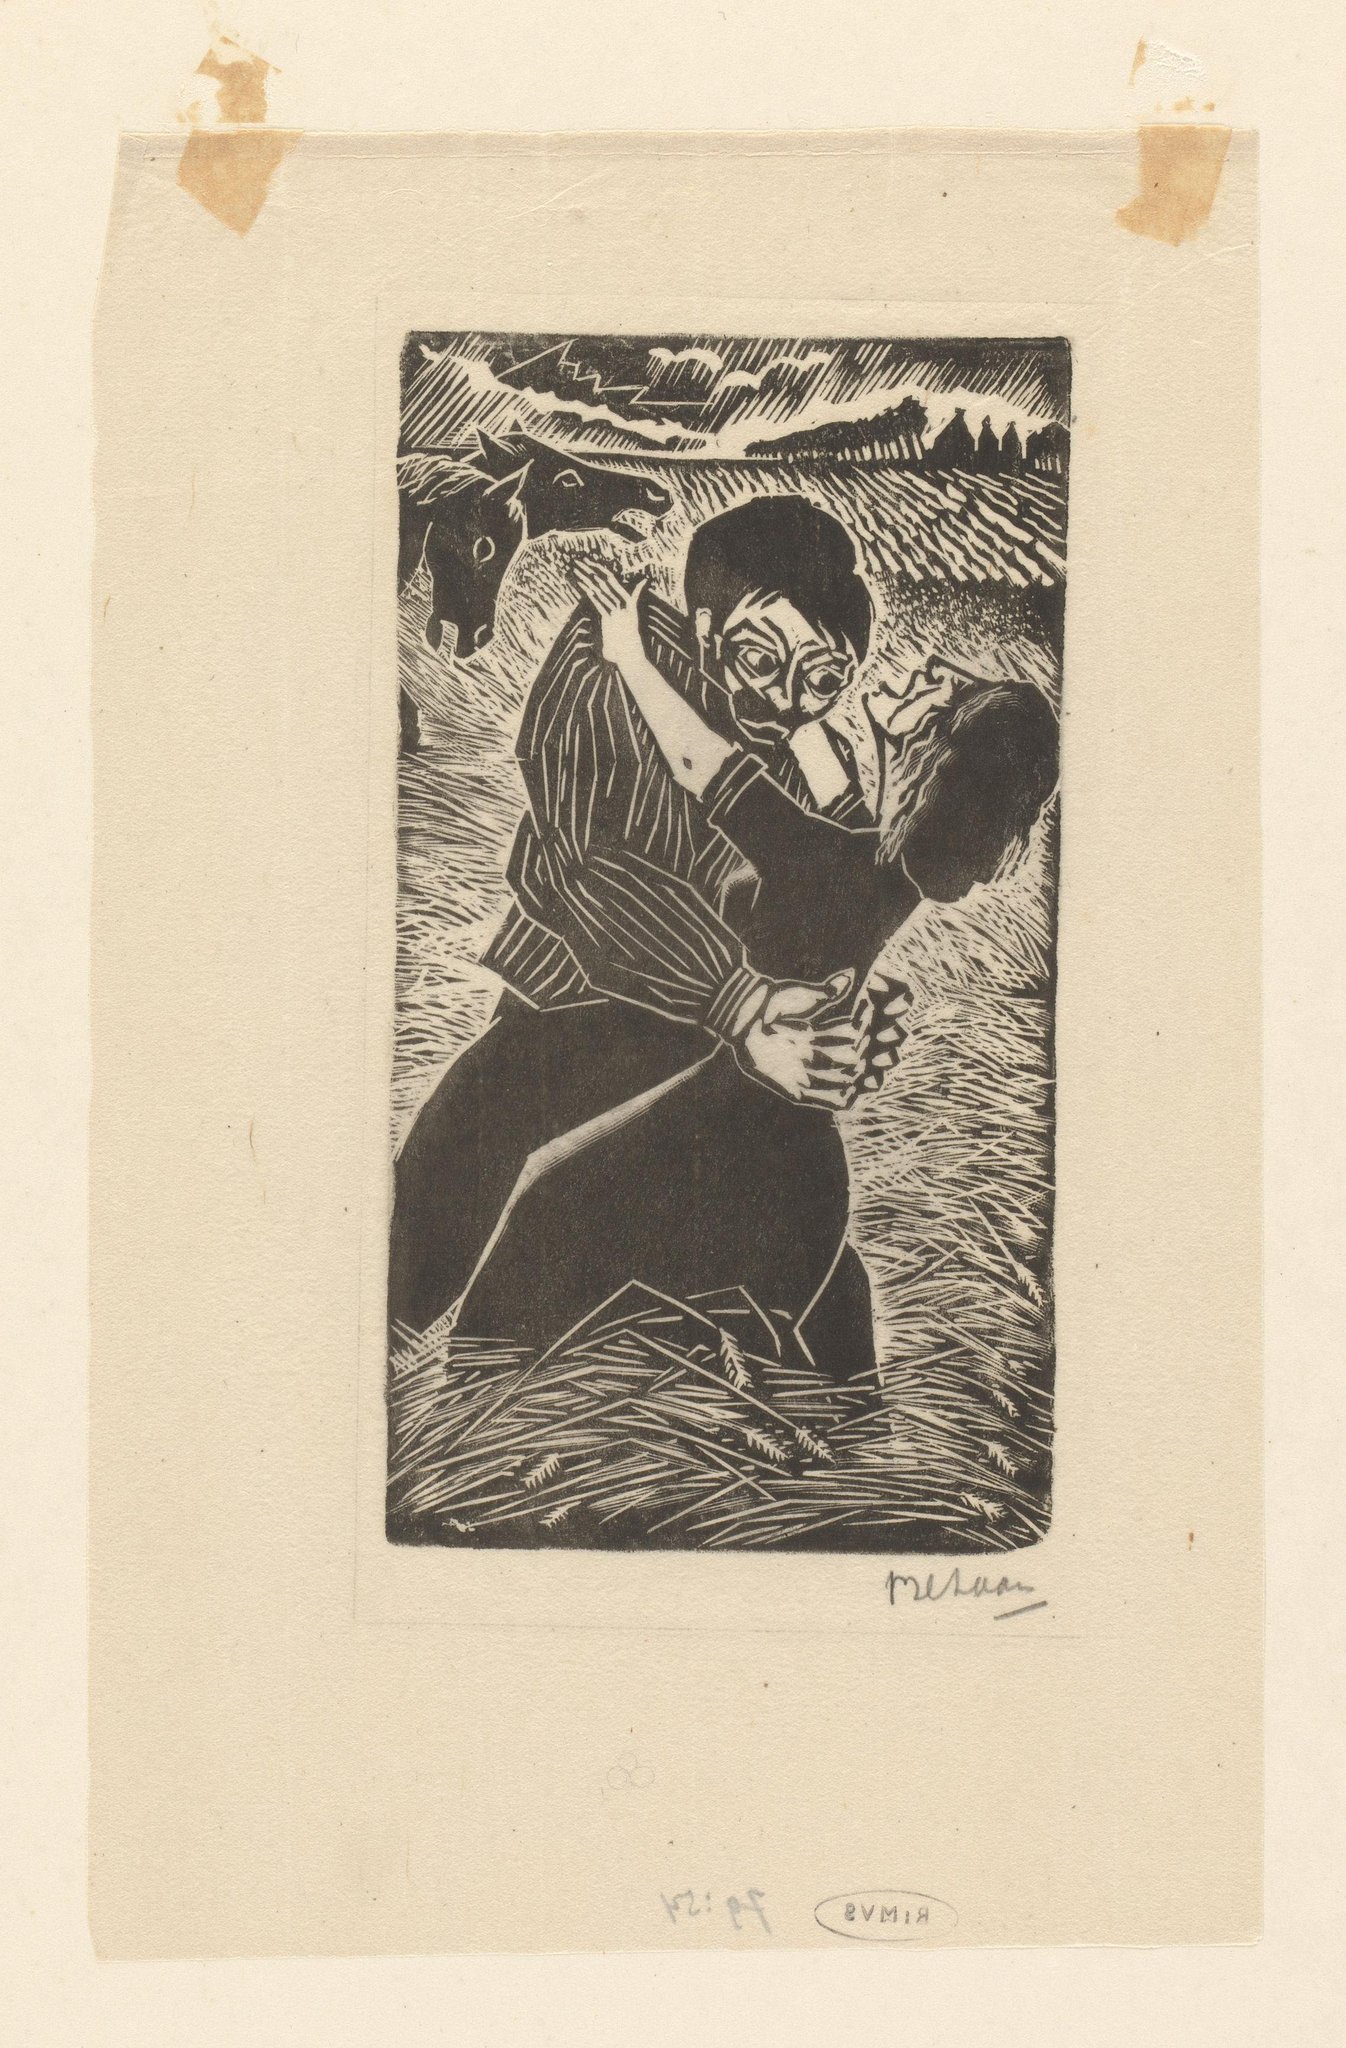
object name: print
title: Man met zijn handen om het middel van een vrouw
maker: jo bezaan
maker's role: draughtsman, print maker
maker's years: 1894-1952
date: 1942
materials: paper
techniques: woodcut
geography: amsterdam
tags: (lovers) embracing each other, 'symplegma'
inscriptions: collector's mark: Lugt 2228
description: Prent gebruikt voor: Buysse, Cyriel. Het leven van Rozeke van Dalen. Amsterdam: Contact-boekerij, 1942.